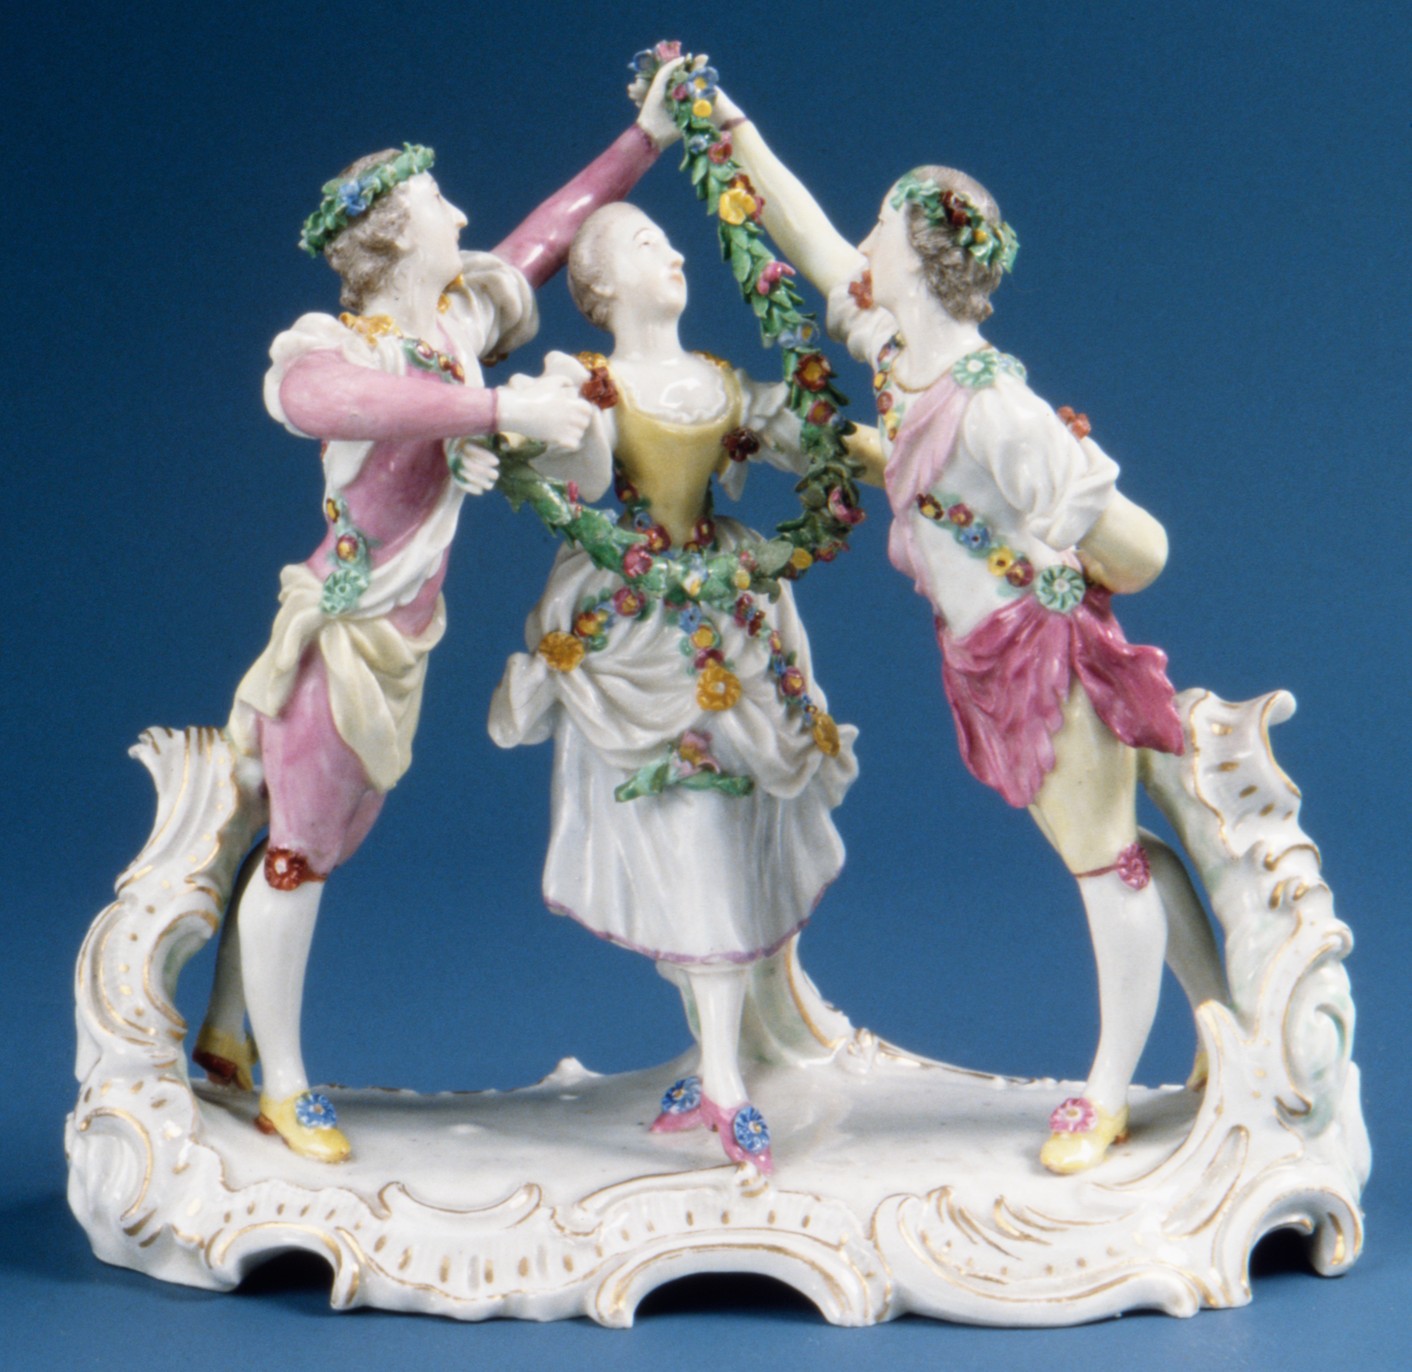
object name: group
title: Pas de Trois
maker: ludwigsburg porcelain manufactory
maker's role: manufactory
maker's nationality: german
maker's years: 1758-1824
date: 1763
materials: hard paste porcelain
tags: garlands,men,women